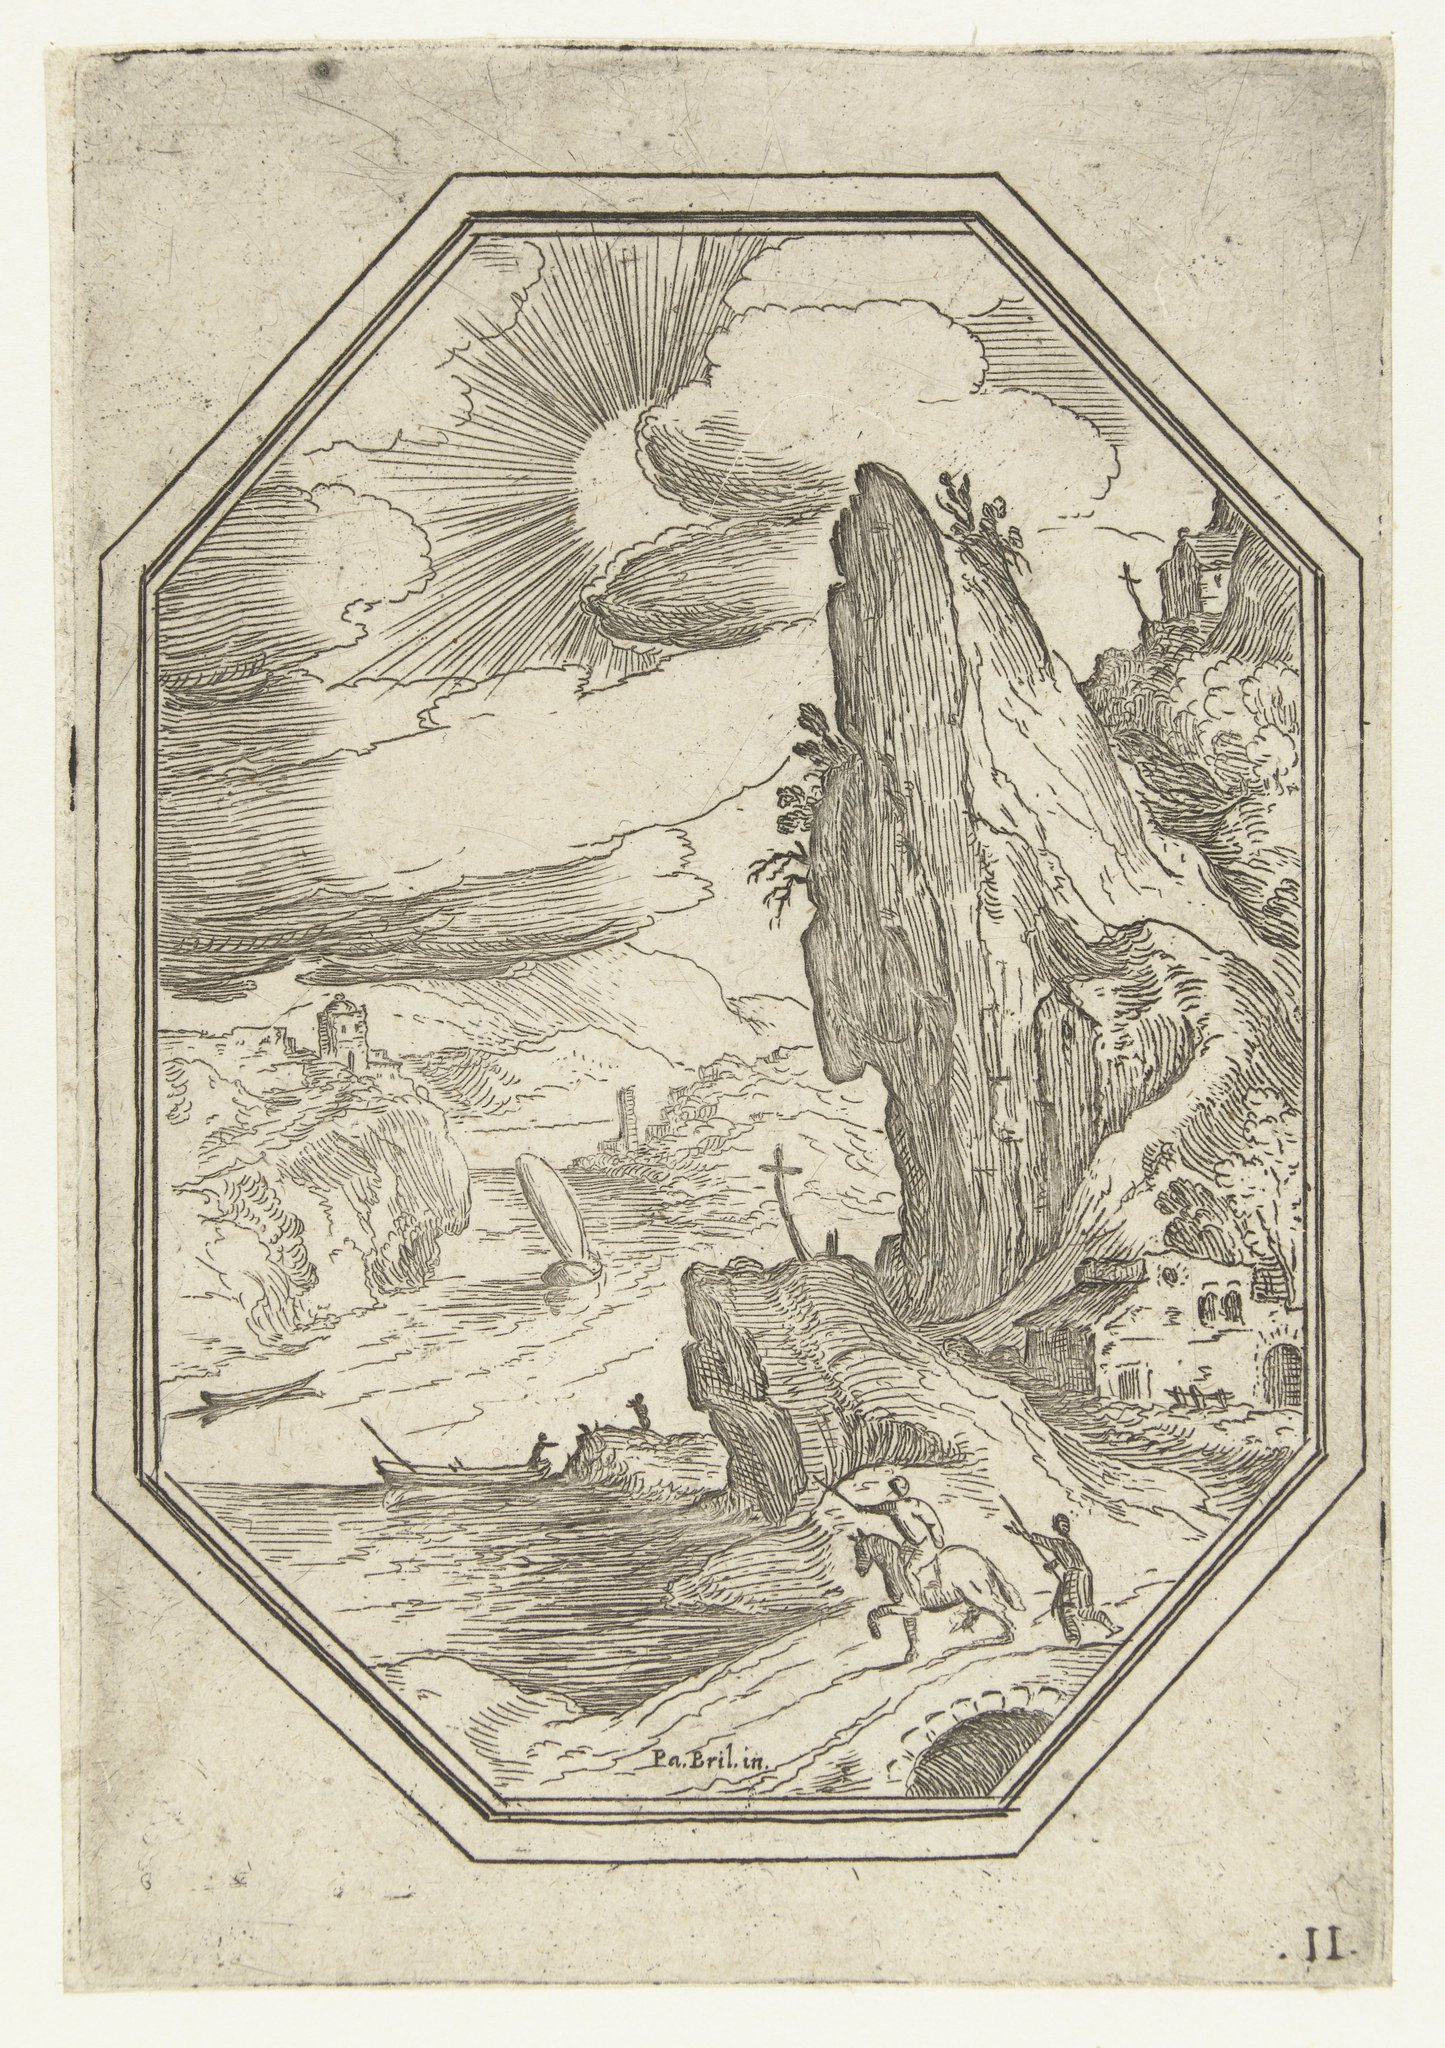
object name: print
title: Octagonale Landschappen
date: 1582-1626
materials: paper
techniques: etching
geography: rome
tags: rocky coast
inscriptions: collector's mark: Lugt 2228a